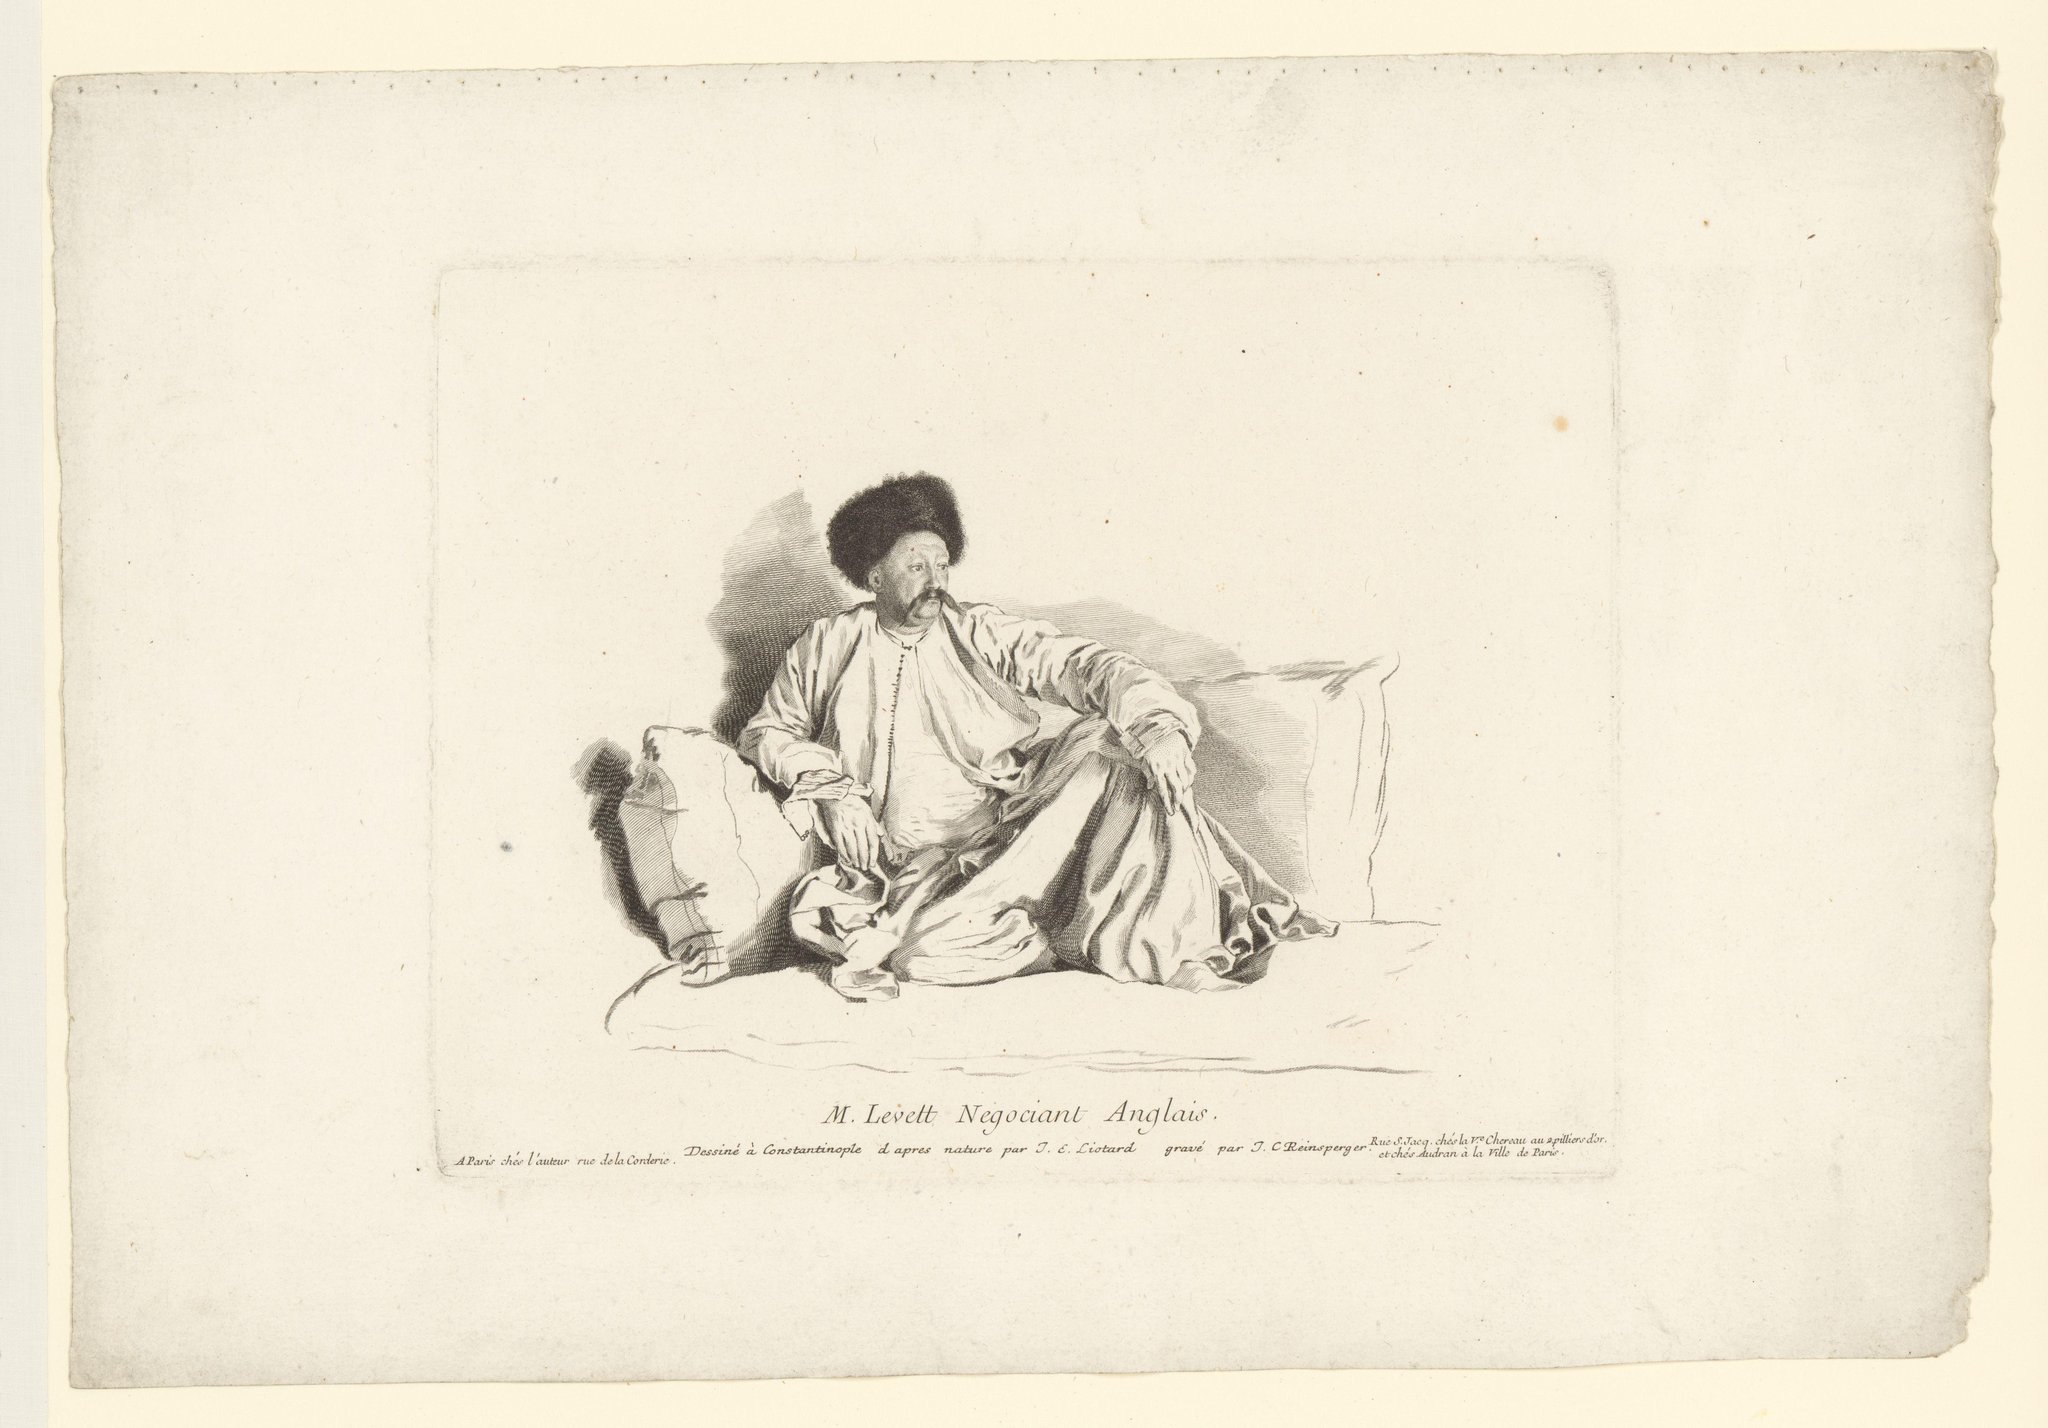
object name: print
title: M. Levett Négociant Anglais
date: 1722-1777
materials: paper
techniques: etching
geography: paris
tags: asiatic races and peoples: turks, historical persons, diplomacy, diplomat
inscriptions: collector's mark: Lugt 2228, collector's mark: Lugt 2760